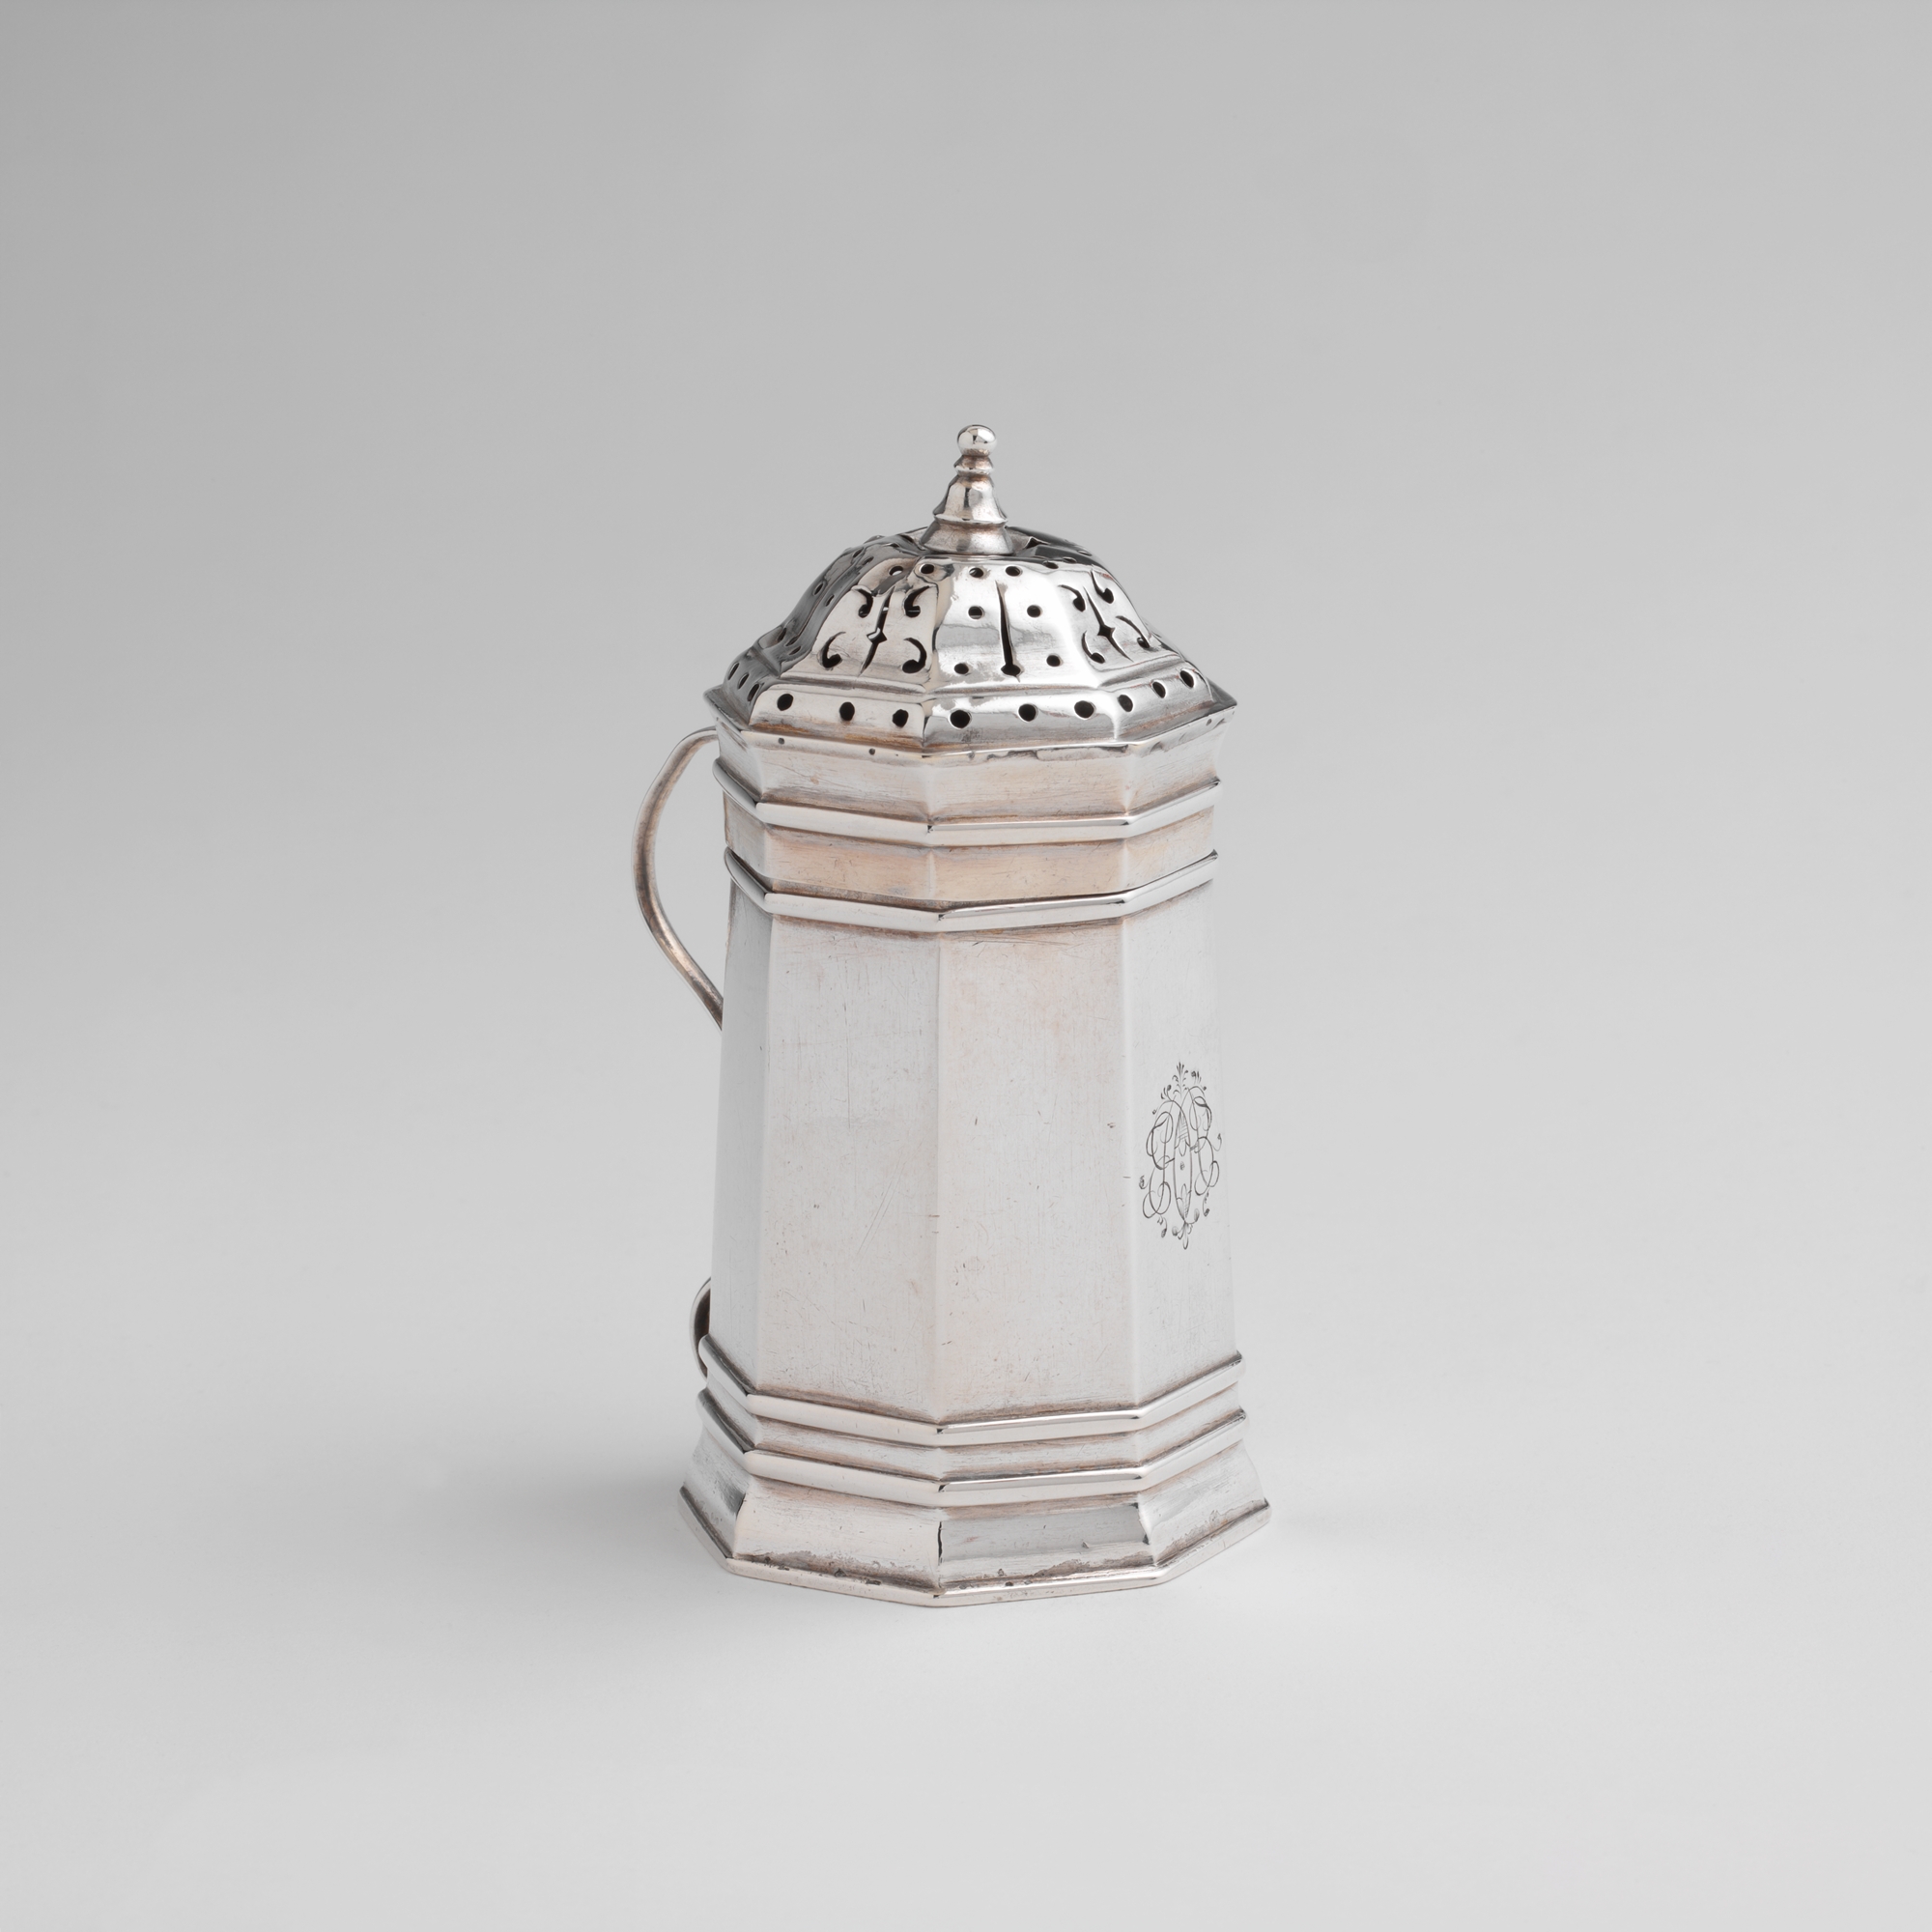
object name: box, caster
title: Pepper Box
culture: american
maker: william breed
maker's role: maker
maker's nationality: american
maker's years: 1719-1761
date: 1755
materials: silver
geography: united states